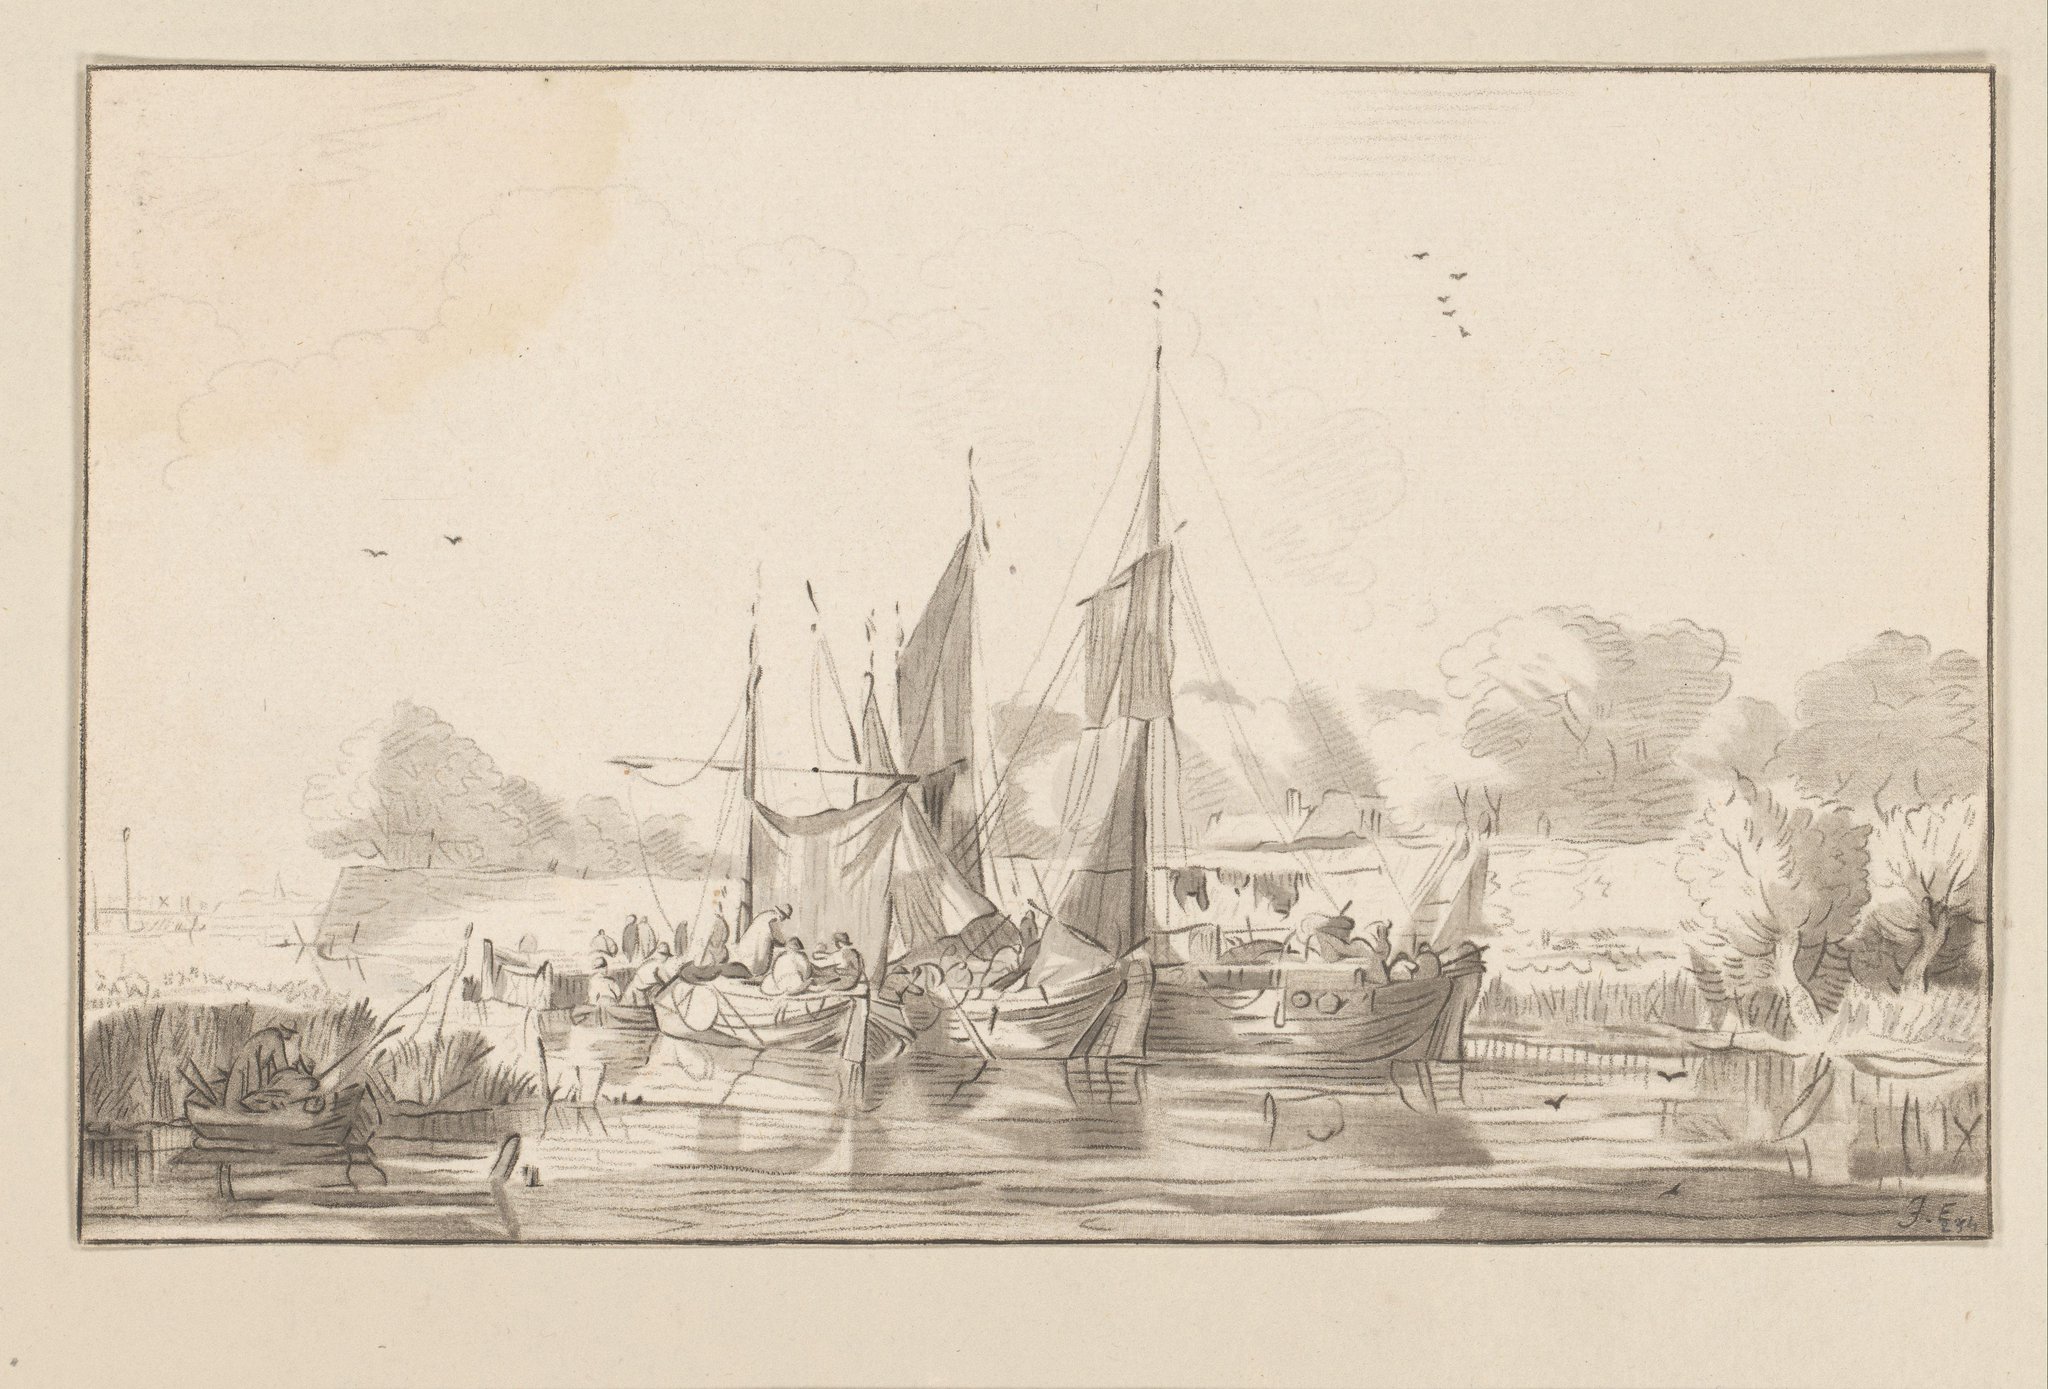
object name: print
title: Riviergezicht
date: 1771-1787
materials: paper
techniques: hand coloring, roulette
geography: amsterdam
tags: sailing-ship, sailing-boat, river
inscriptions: collector's mark: ‘RIJKS / MUSM’, collector's mark: Lugt 2725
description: Riviergezicht met verschillende zeilschepen en sloepen, die naast elkaar voor anker liggen. De prent ligt los in een album, zie blad 46.